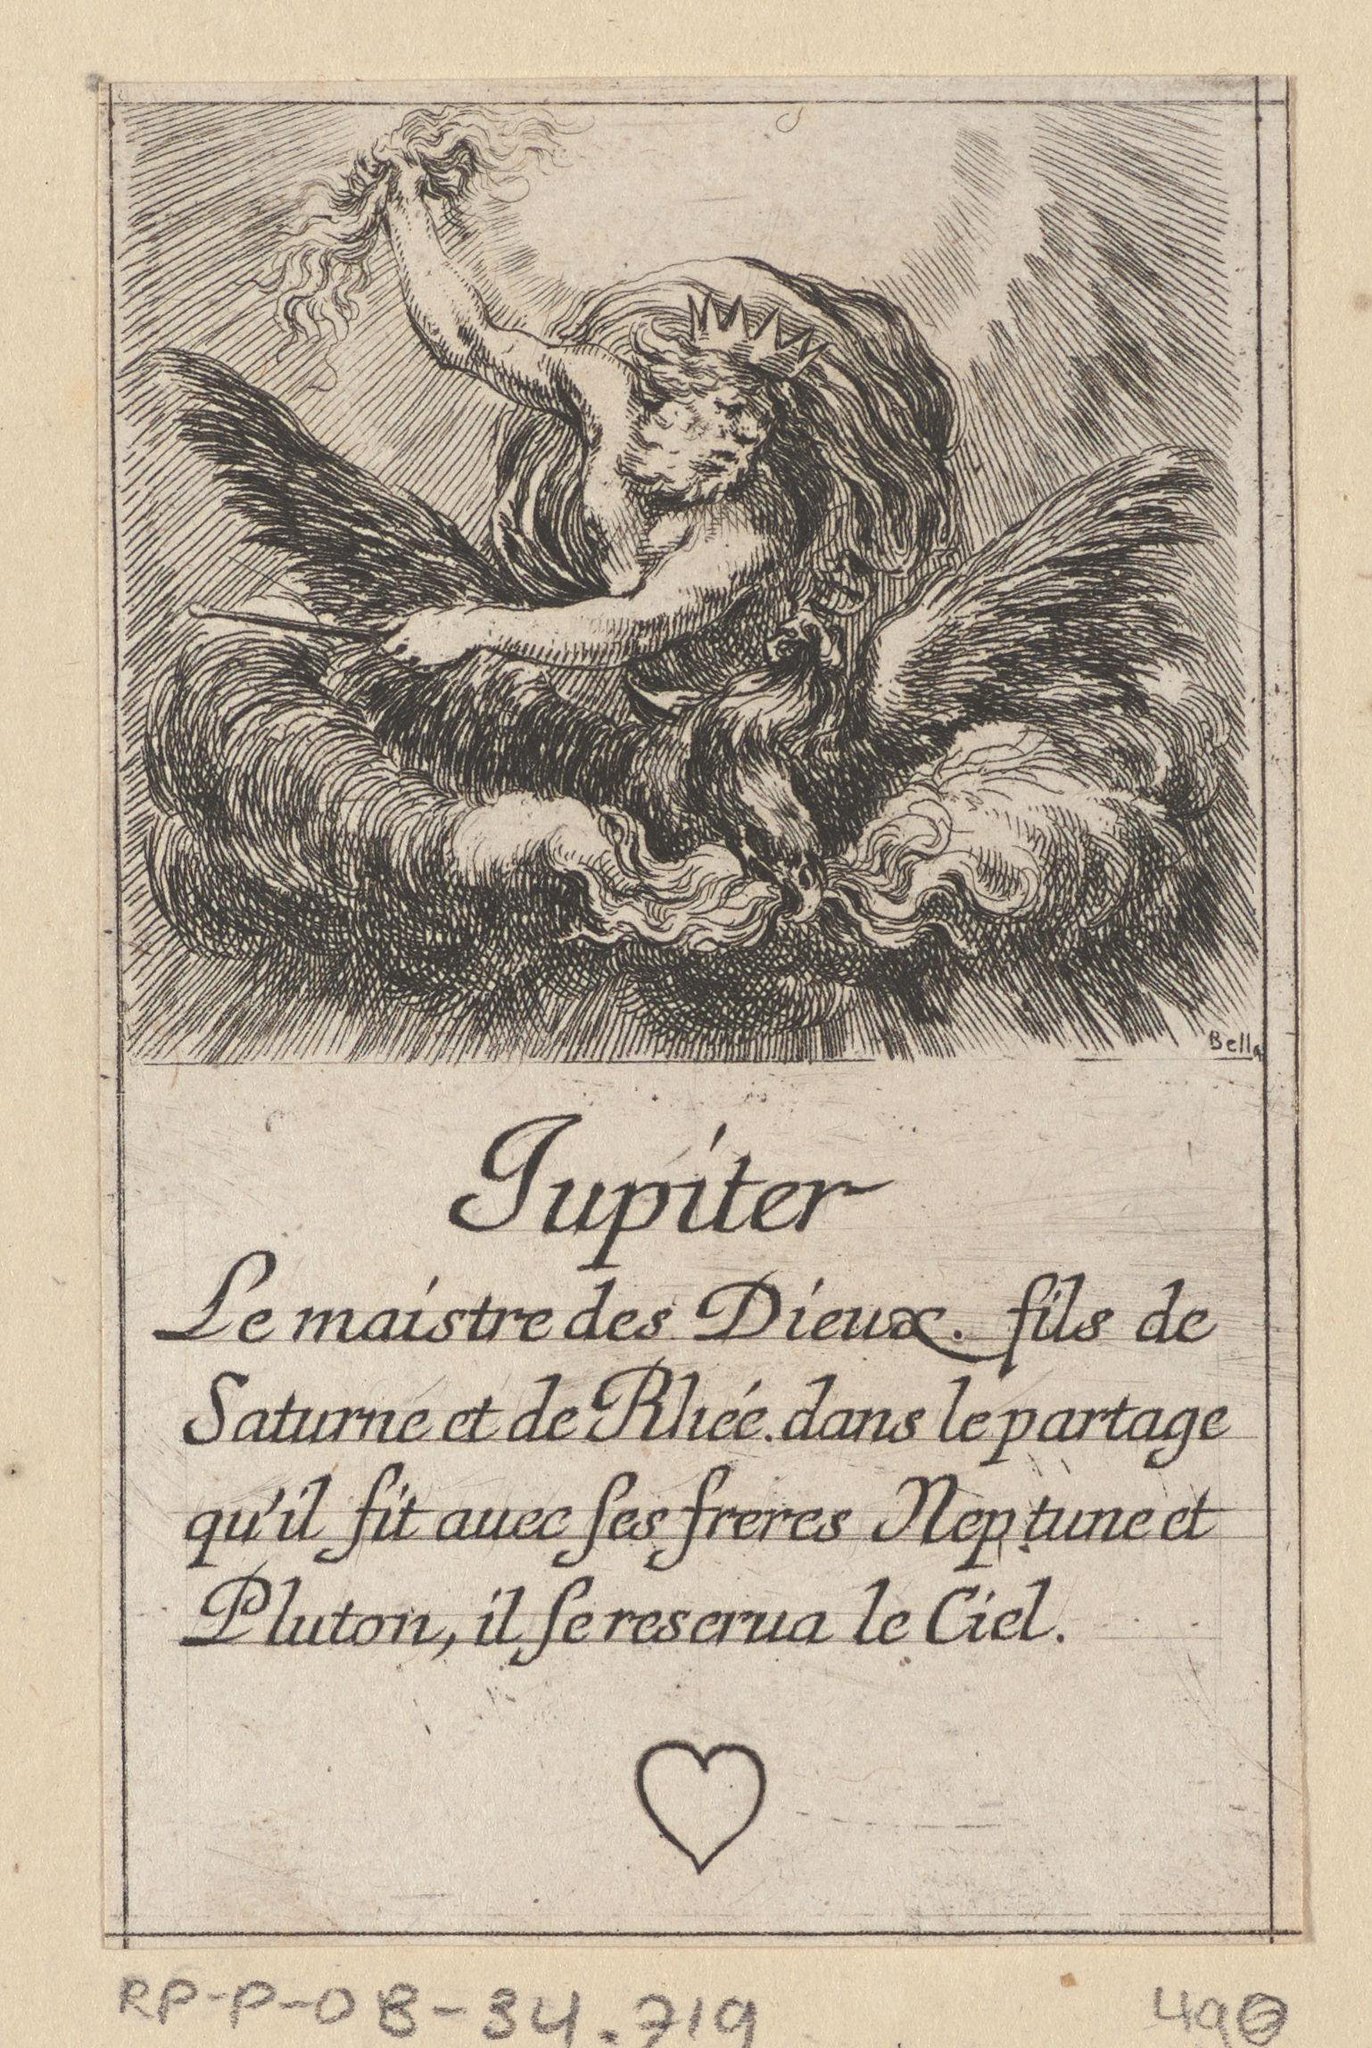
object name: playing card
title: Jupiter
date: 1620-1664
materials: paper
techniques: etching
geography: paris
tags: (story of) jupiter (zeus), attributes of jupiter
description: Deze prent maakt deel uit van een kaartspel met 52 kaarten met voorstellingen uit de Metamorfosen van Ovidius. De serie is uitgedacht door Jean Desmarests de Saint-Sorlin in opdracht van Kardinaal Mazarin. Het kaartspel werd gemaakt voor de jonge Lodewijk XIV, samen met het Jeu des Reynes Renommées, Jeu de la Géographie en Jeu des Rois de France.